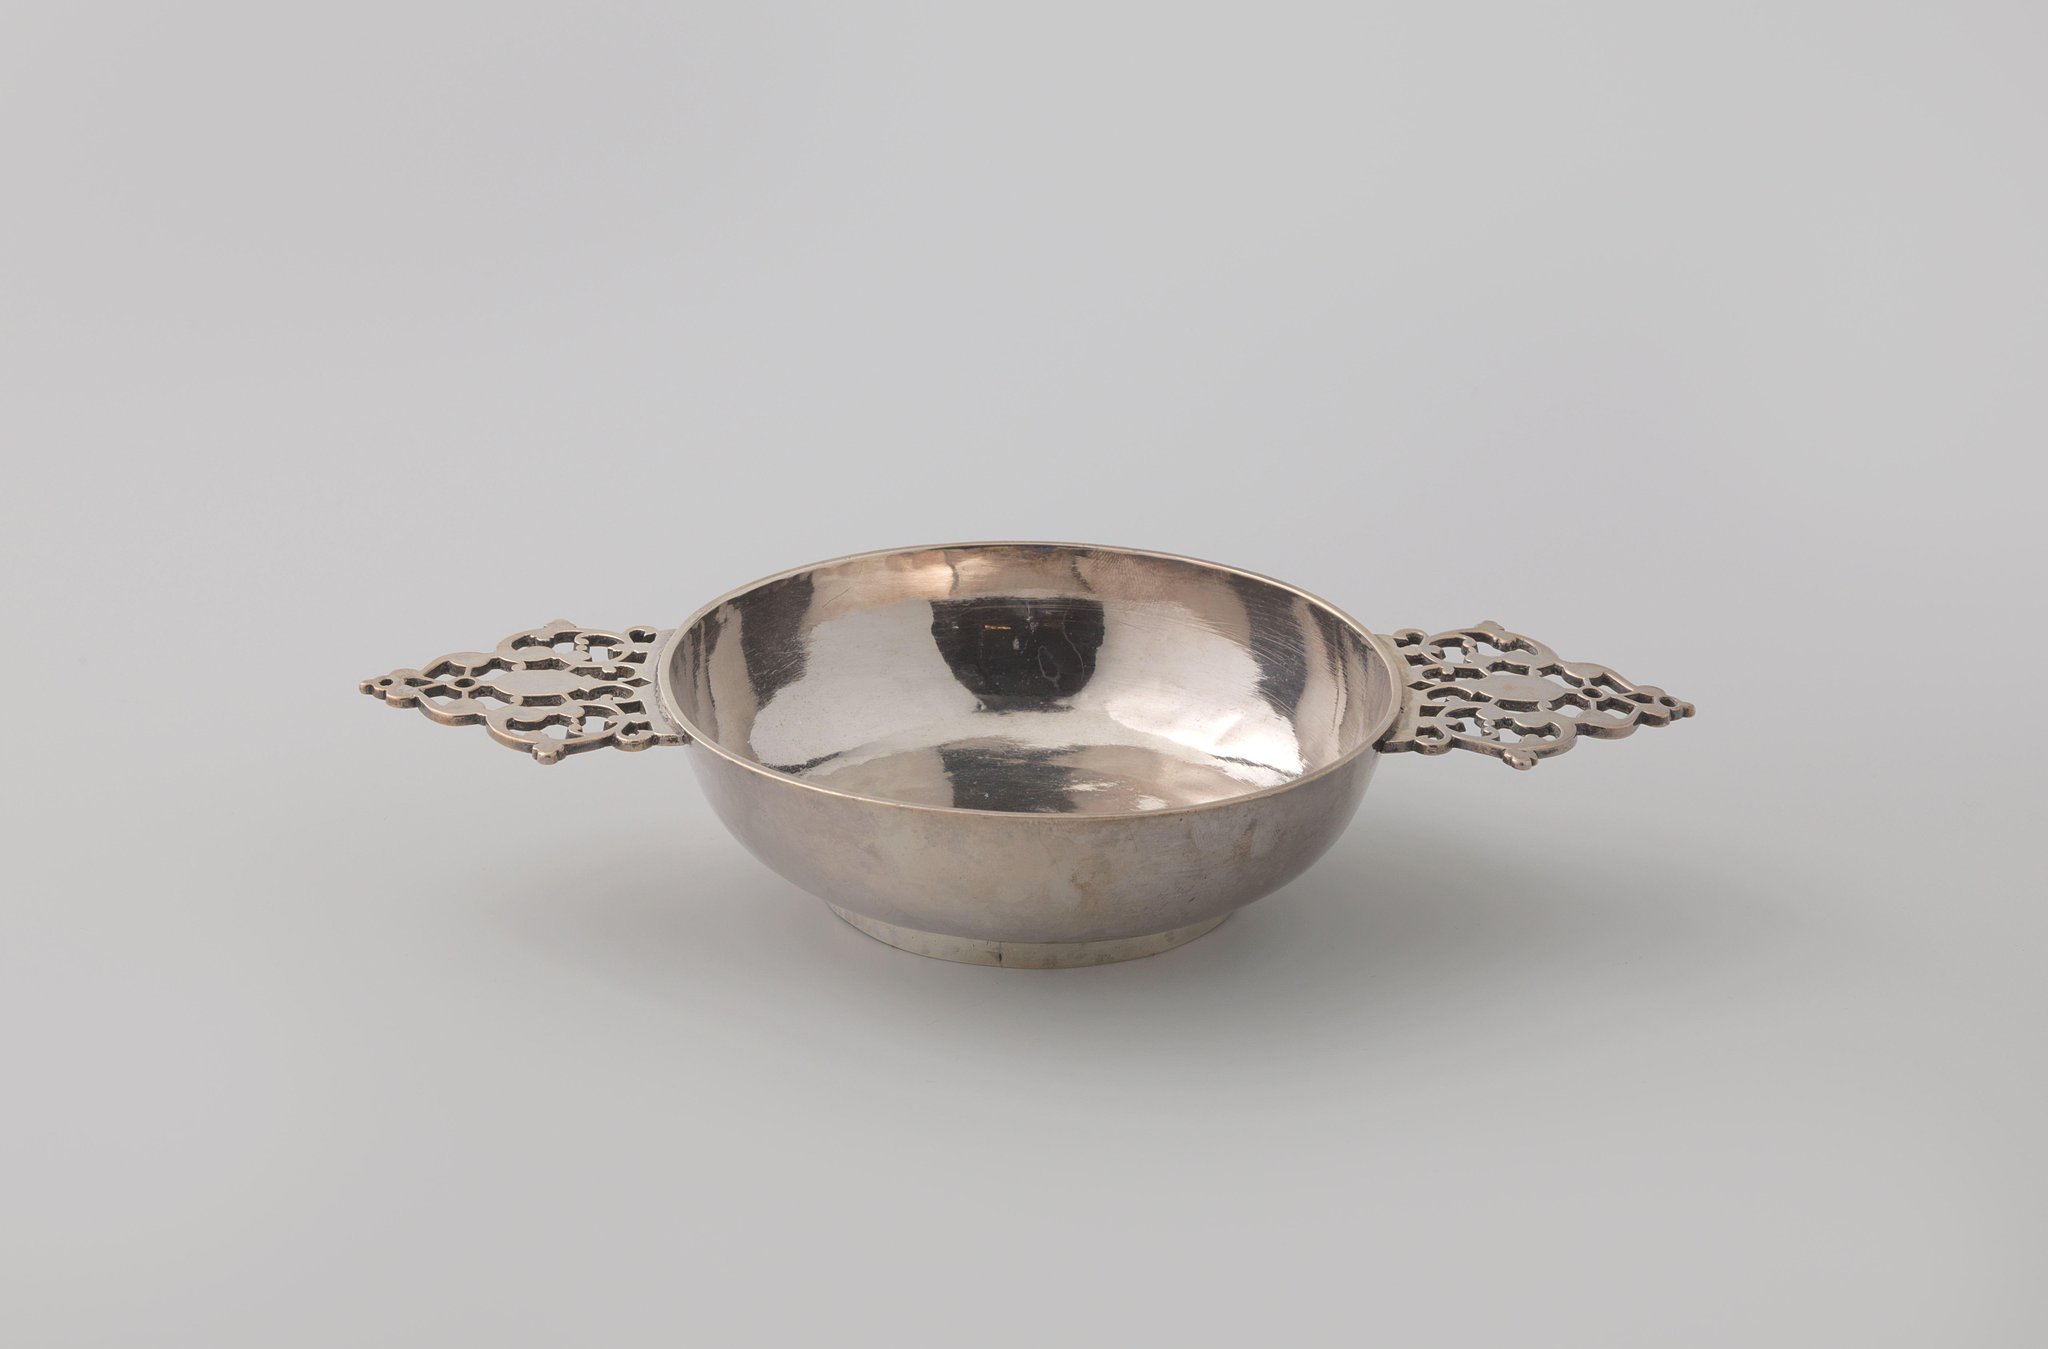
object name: drinking bowl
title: Brandewijnskom van zilver op lage, ronde, onversierde cuppa met twee horizontale uitgezaagde oren. Vals.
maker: jan verdoes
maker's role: jeweler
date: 1746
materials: silver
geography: haarlem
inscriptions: mark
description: Brandewijnkom van zilver. Lage, ronde onversierde cuppa met twee horizontale oren, bestaande uit gezaagd, symmetrisch bandornament.